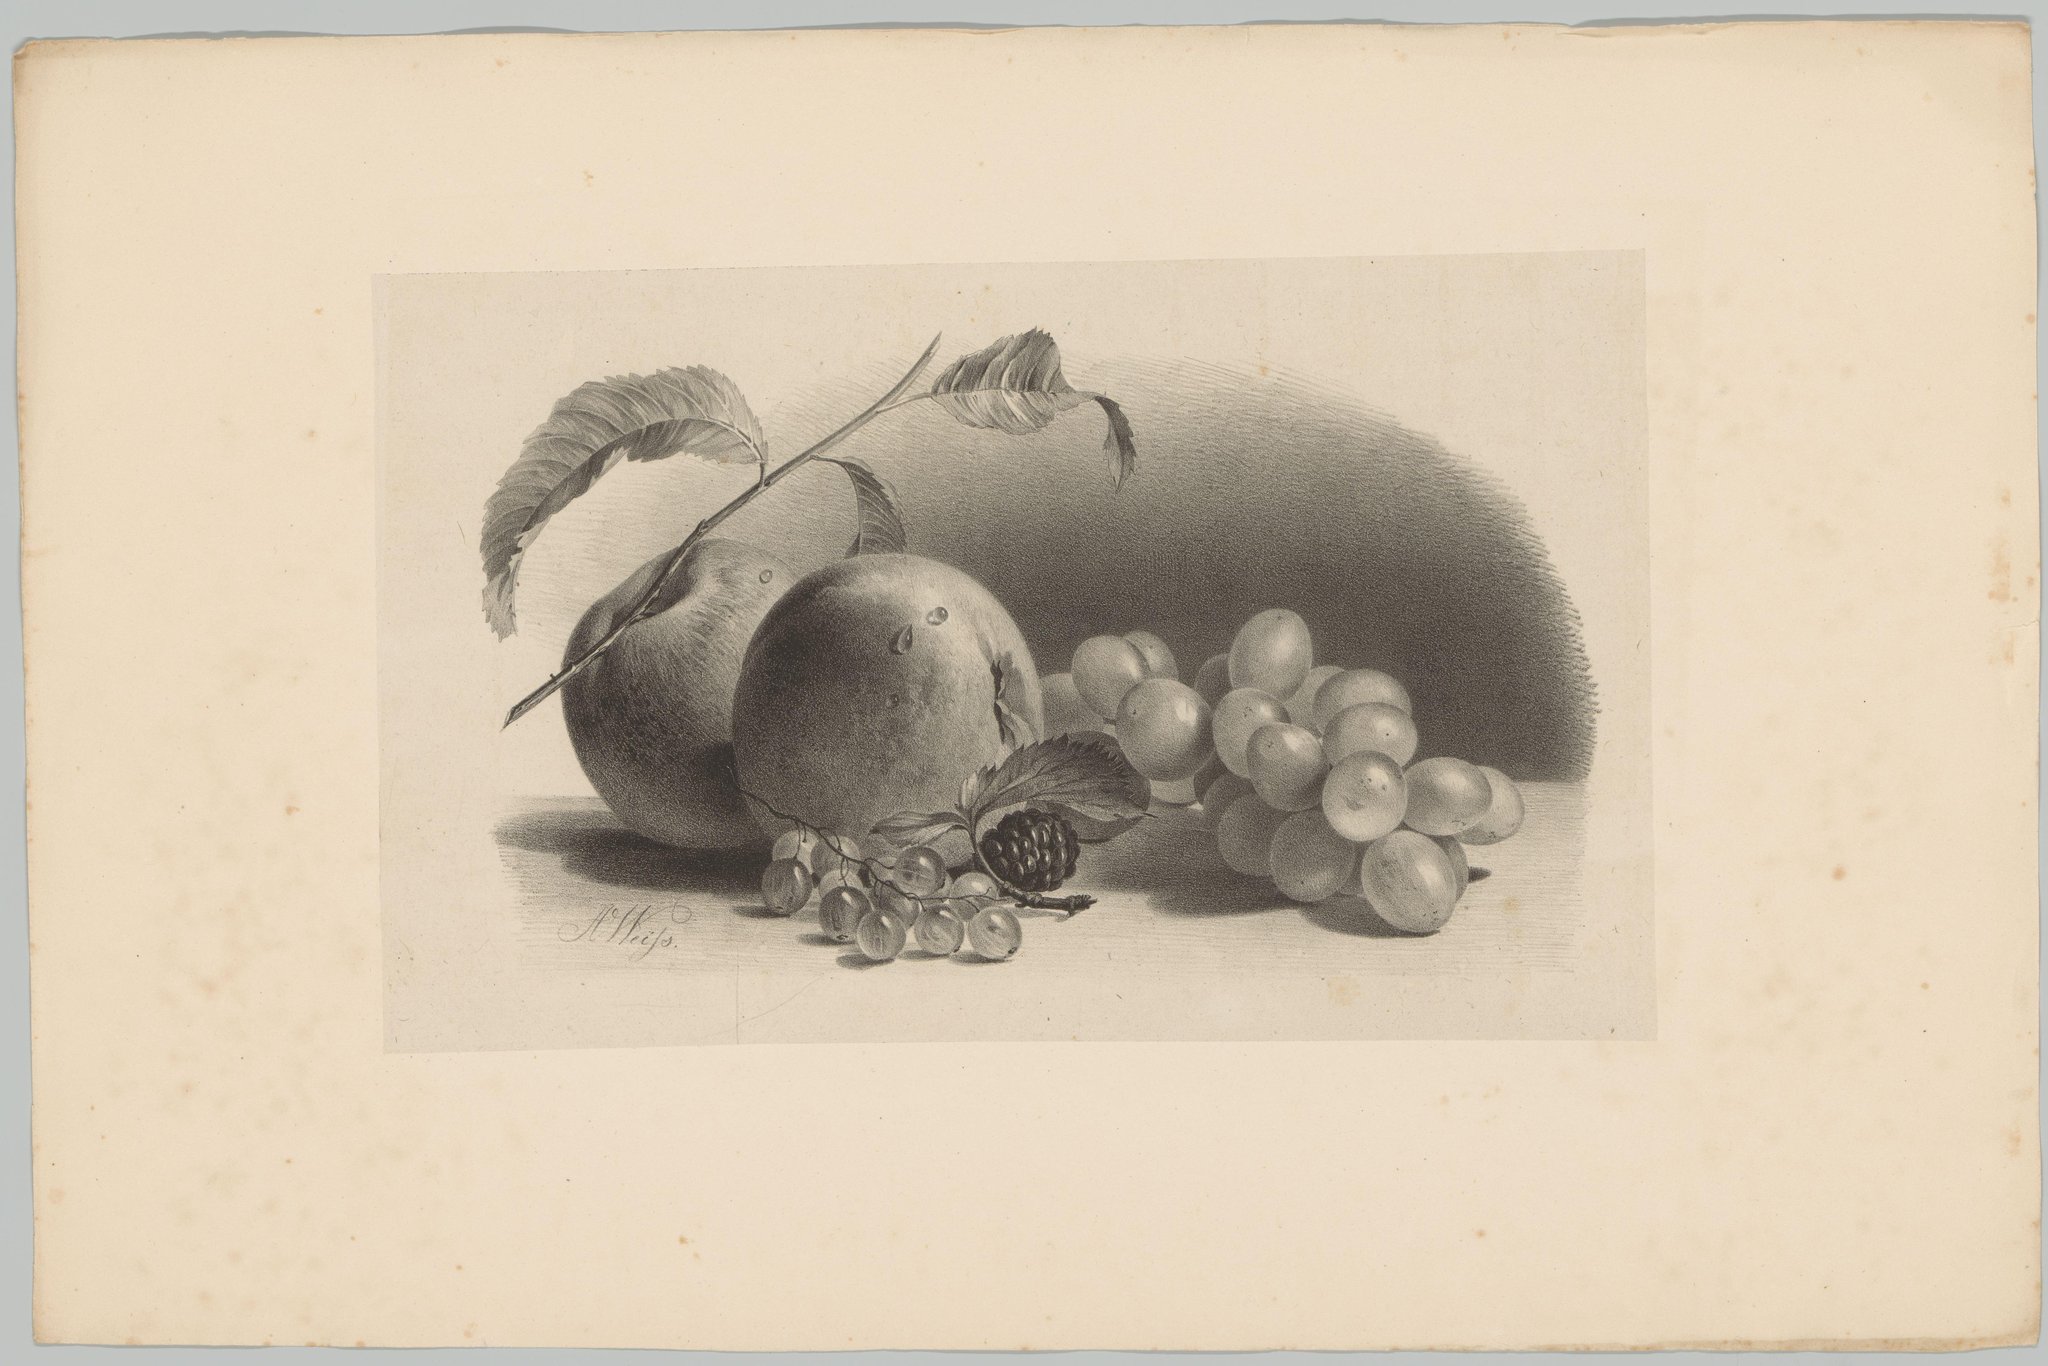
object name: print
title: Appels, bessen, braam en druiven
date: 1820-1833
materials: paper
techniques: lithograph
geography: amsterdam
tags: fruits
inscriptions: collector's mark: Lugt 2228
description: Onderdeel van een omslag met in totaal zevenenzeventig lithografieën van bloemen en fruit.